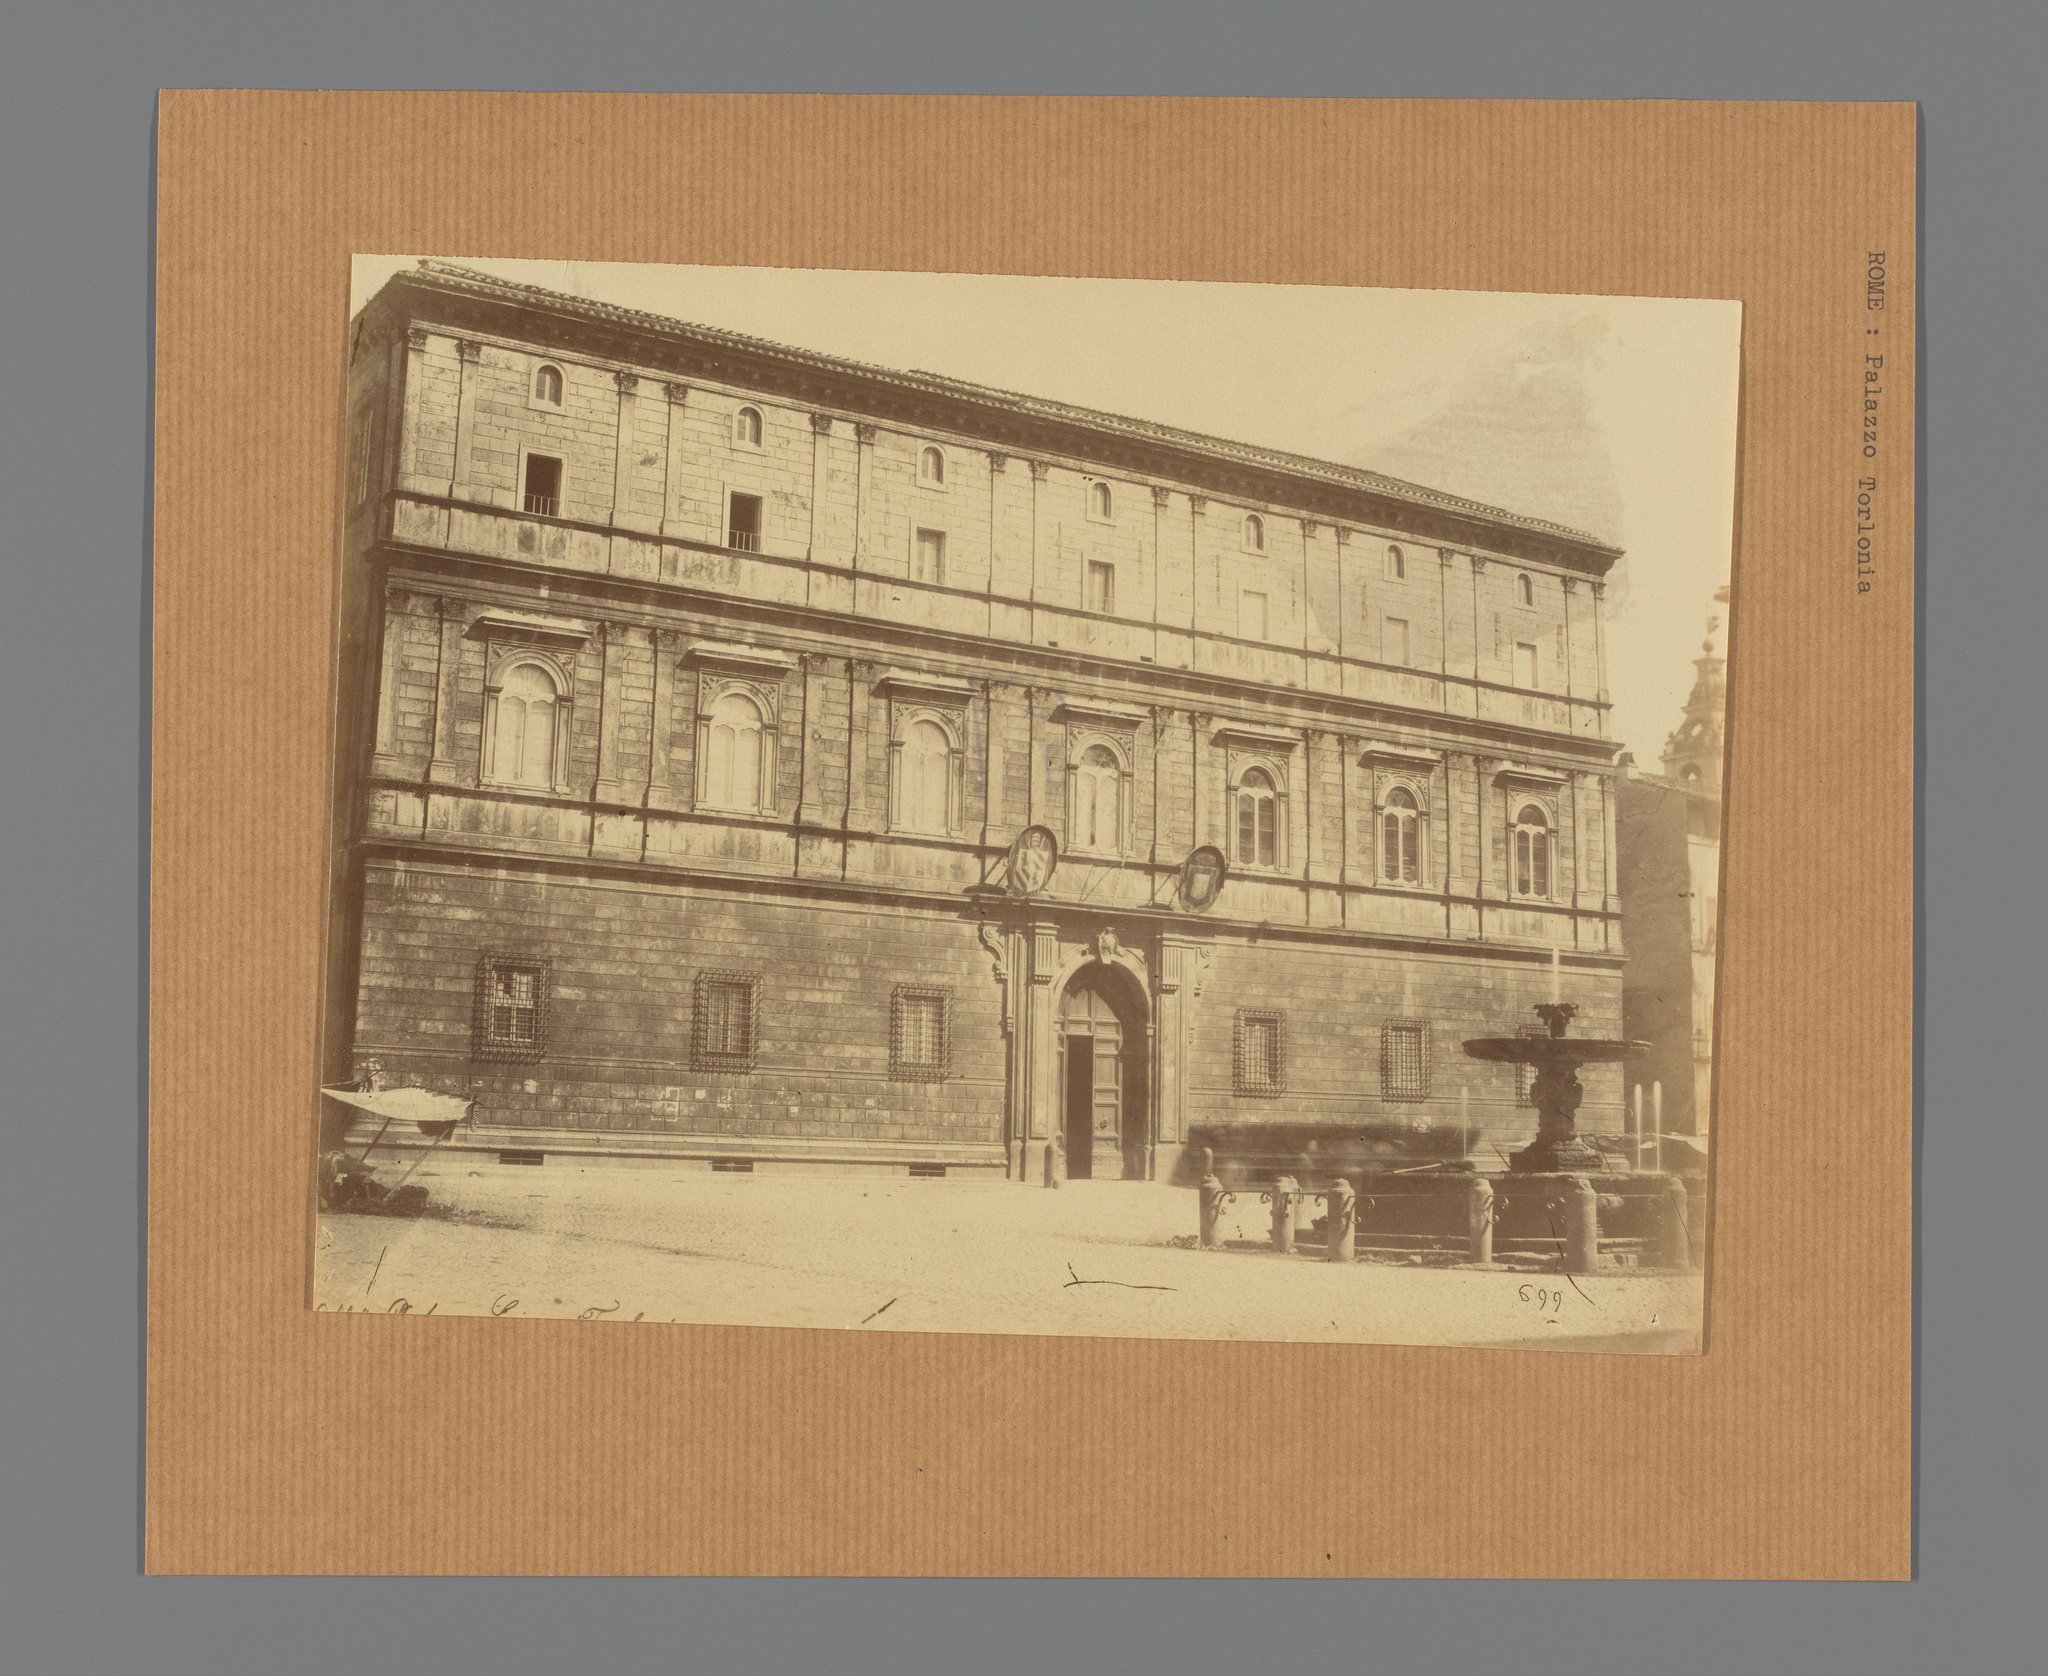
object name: photograph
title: Rome: Palazzo Torlonia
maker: Anonymous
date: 1850-1899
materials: paper, photographic support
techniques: albumen print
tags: palazzo torlonia